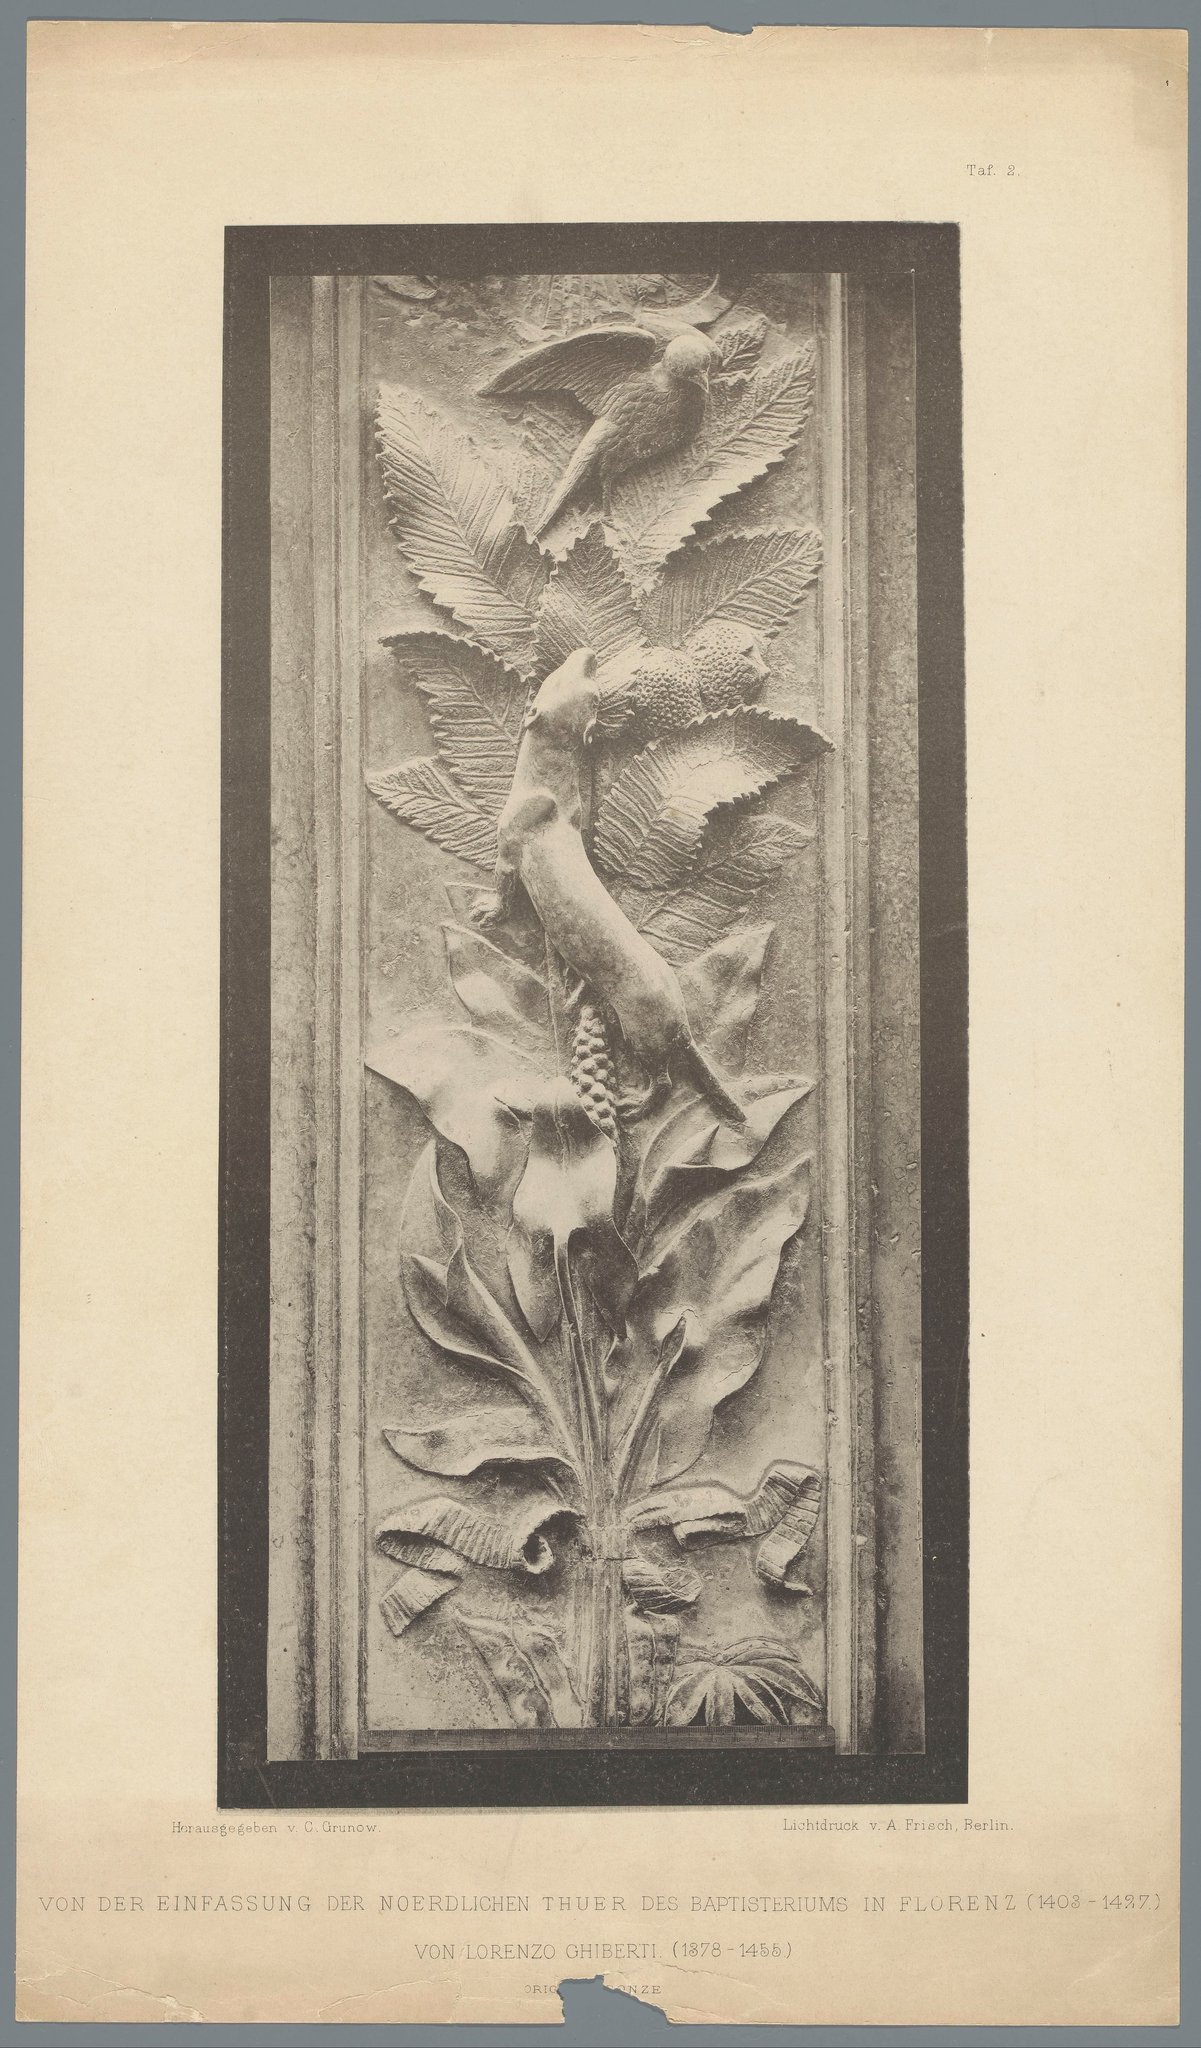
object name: photograph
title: VON DER EINFASSUNG DER NOERDLICHEN THUER DER BAPTISTERIUMS IN FLORENZ (1403-1427.) VON LORENZO GHIBERTI. (1378-1455.)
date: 1875-1900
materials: paper, ink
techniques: photograph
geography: florence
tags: birds, beasts of prey, predatory animals: ferret, sculpture (+ relief ~ sculpture)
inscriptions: number: ‘Taf. 2.’, collector's mark: Lugt 3937